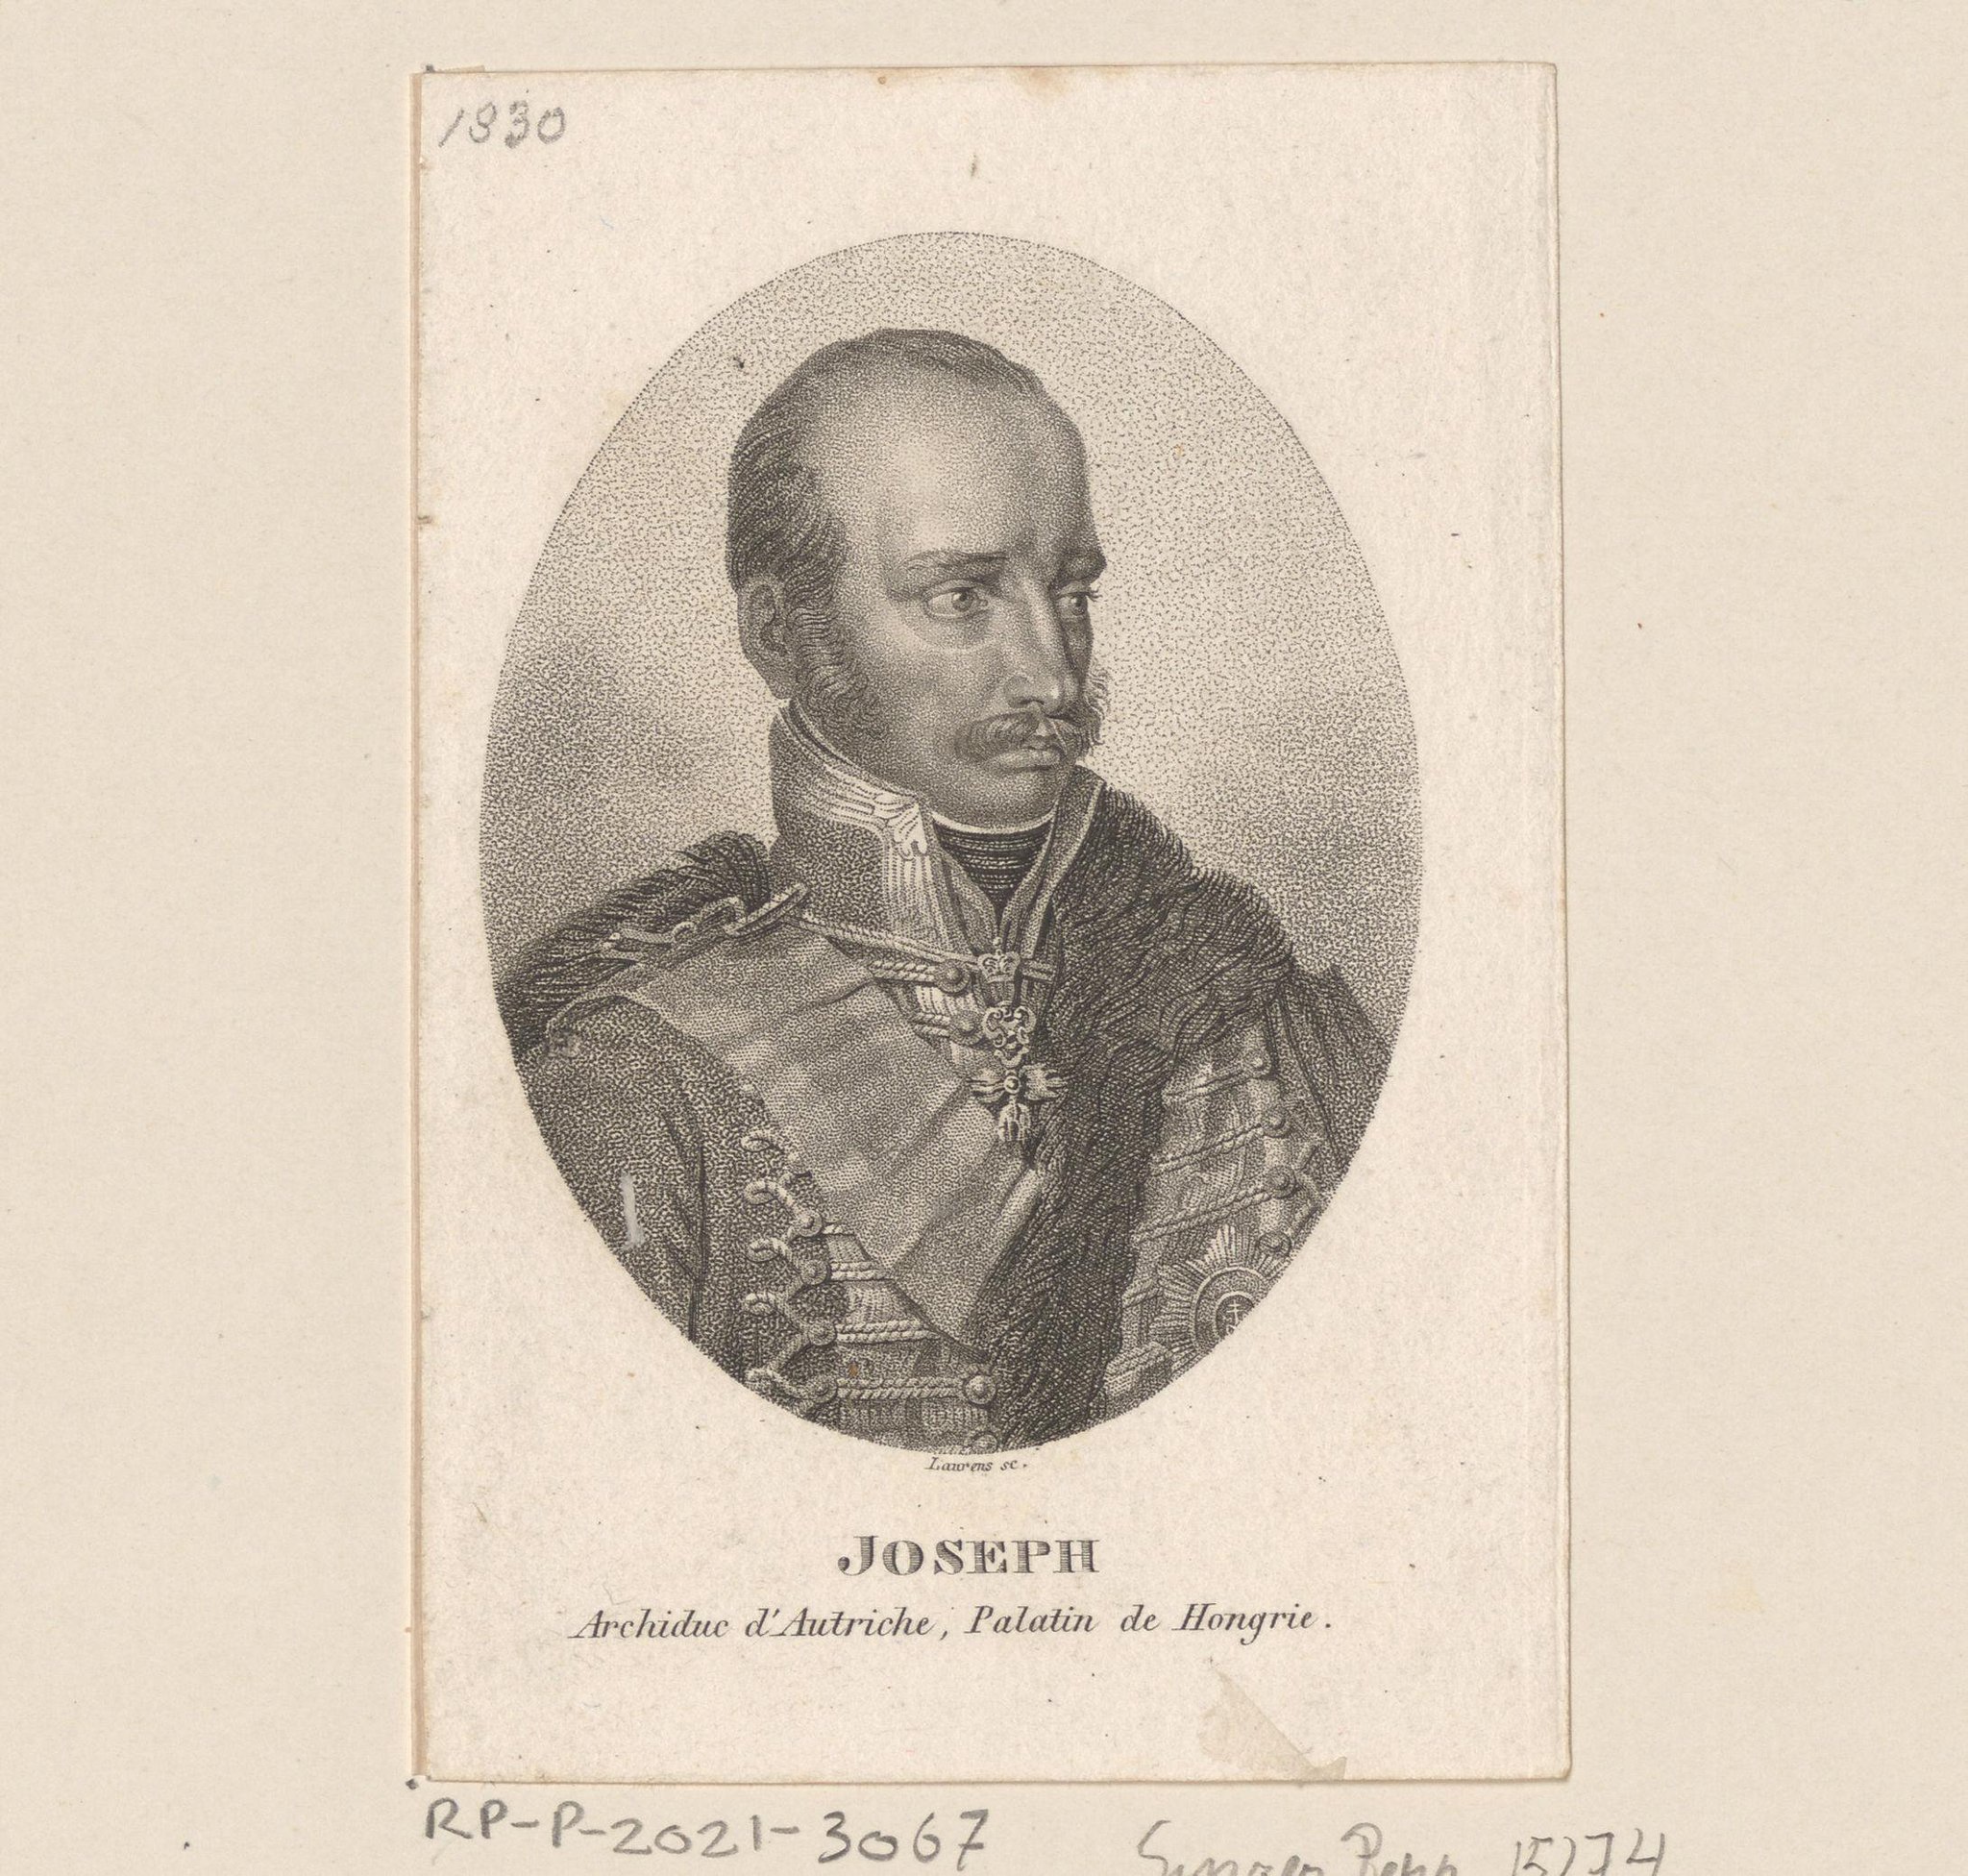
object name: print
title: Portret van Jozef Anton Johan van Oostenrijk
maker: laurens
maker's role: print maker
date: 1796-1850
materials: paper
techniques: engraving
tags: historical persons, ruler, sovereign